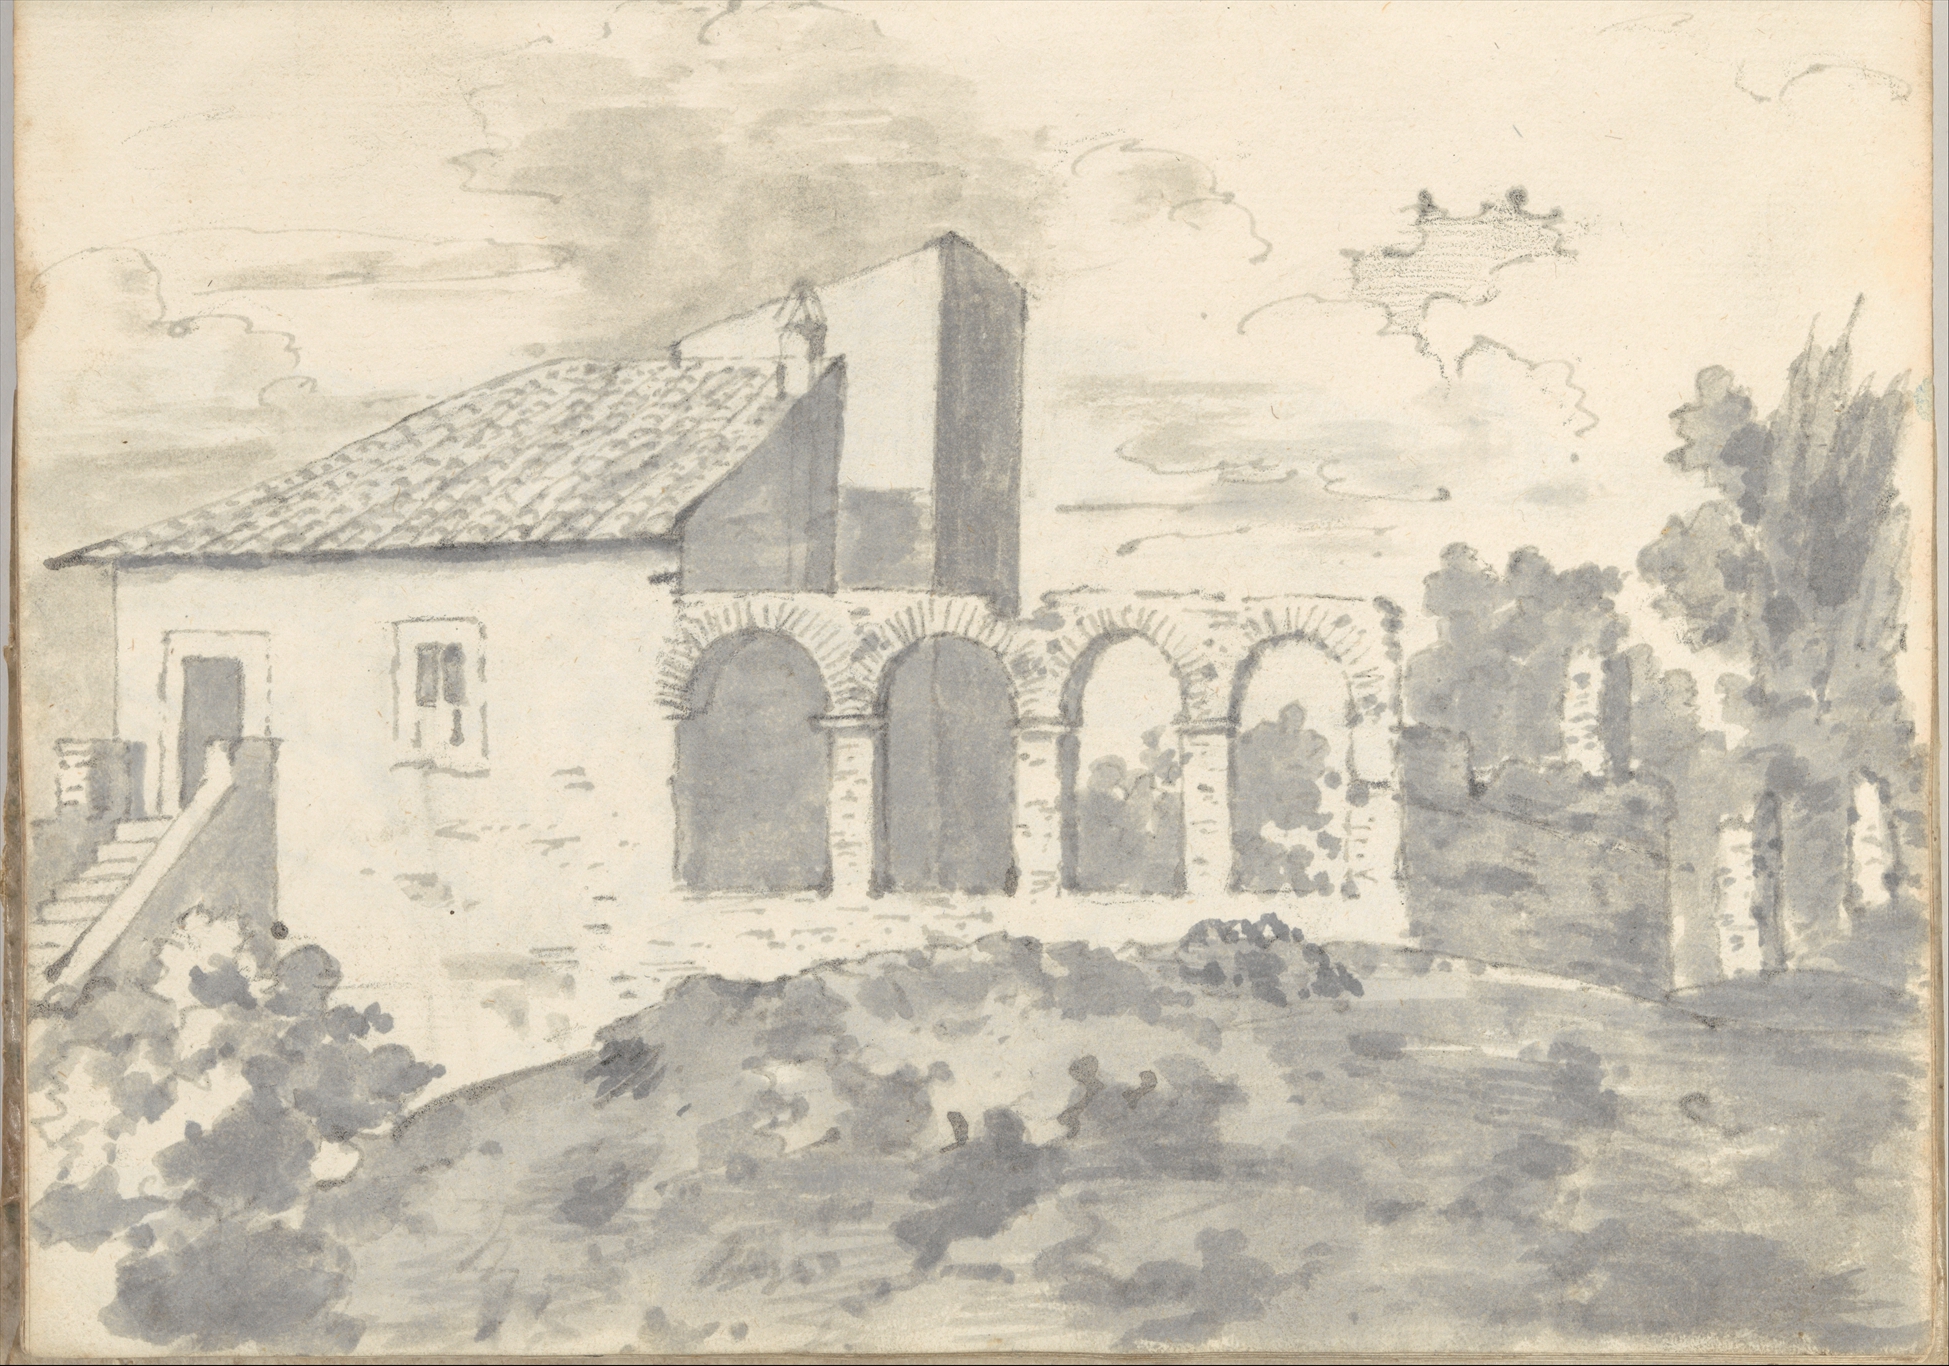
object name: drawing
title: Tile-roofed building with an arcade, part of the walls at Rome (Smaller Italian sketchbook, leaf 31 recto)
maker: joseph wright (wright of derby)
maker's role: artist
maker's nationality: british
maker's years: 1734-1797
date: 1774-1775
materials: graphite, ink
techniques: brush, wash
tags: buildings